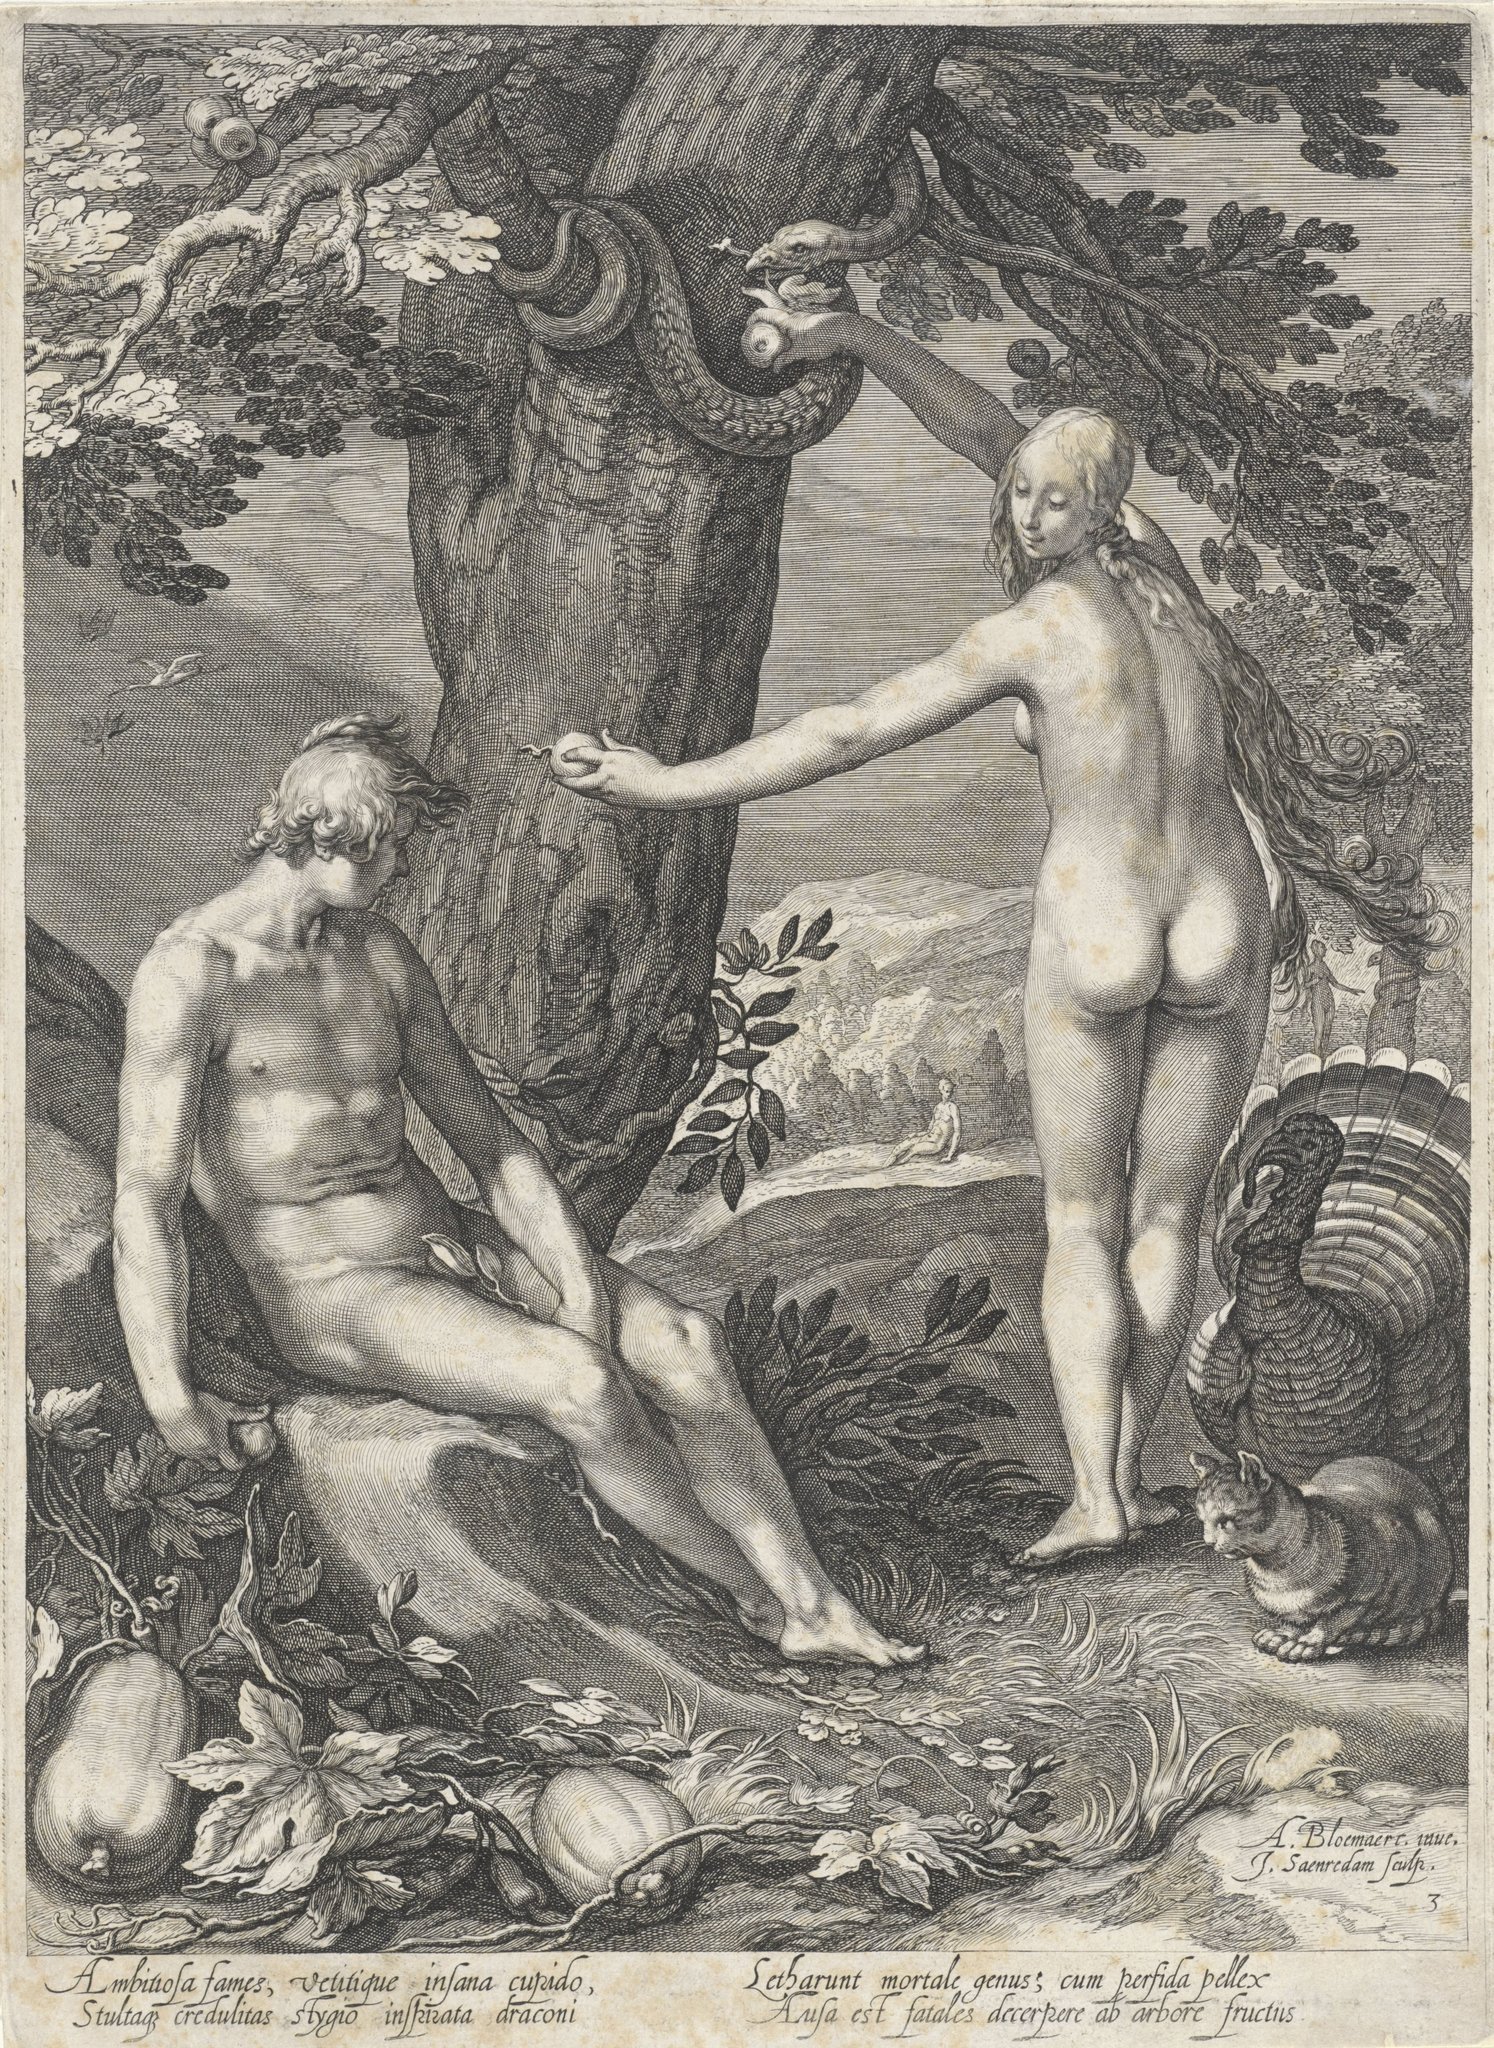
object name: print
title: Zondeval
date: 1604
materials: paper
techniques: engraving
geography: assendelft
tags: eve simultaneously offers some of the fruit to adam and takes some more from the serpent (or the tree), cat, the serpent tries to persuade eve to take some of the fruit (usually an apple), walker and runner birds: turkey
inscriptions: collector's mark: Lugt 10, collector's mark: Lugt 11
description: Eva biedt Adam een appel aan van de boom der kennis van goed en kwaad. Rond de stam van de boom is een slang gekronkeld die Eva een andere appel aanreikt. Op de achtergrond wordt Eva verleid door de slang.